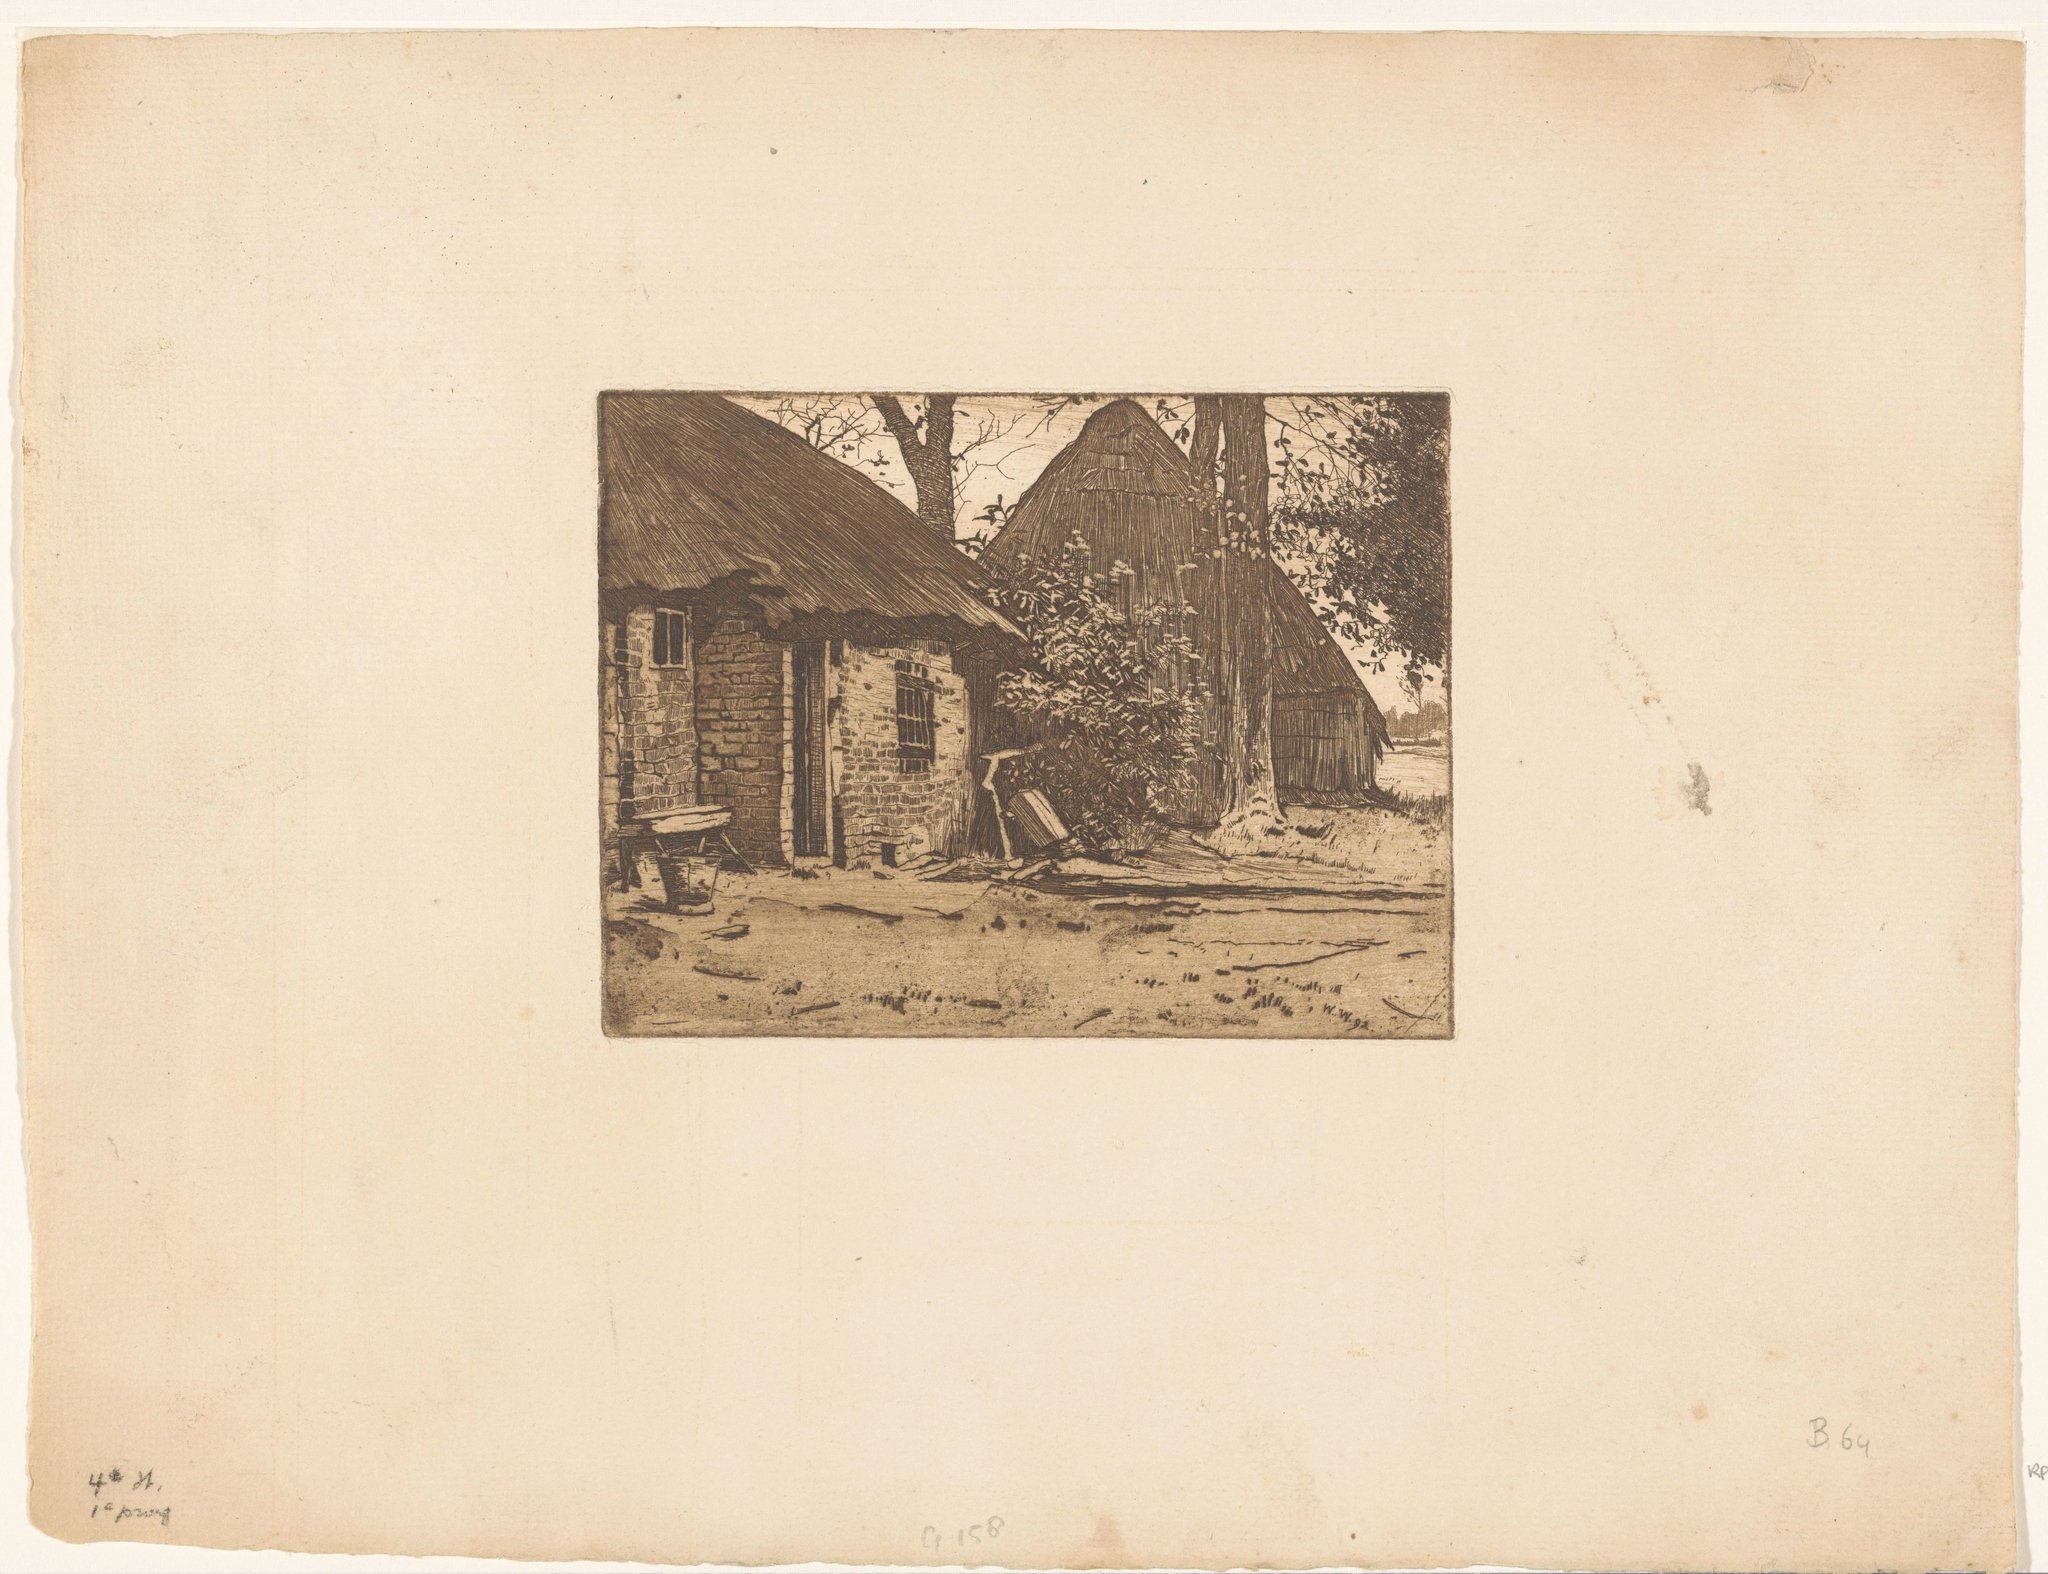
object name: print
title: Boerderij met schuur in Brabant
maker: willem witsen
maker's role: draughtsman, painter, print maker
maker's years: 1860-1923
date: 1892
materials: paper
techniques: aquatint, etching, intaglio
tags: barn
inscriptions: watermark, inscription: ‘4e st. 1e proef’